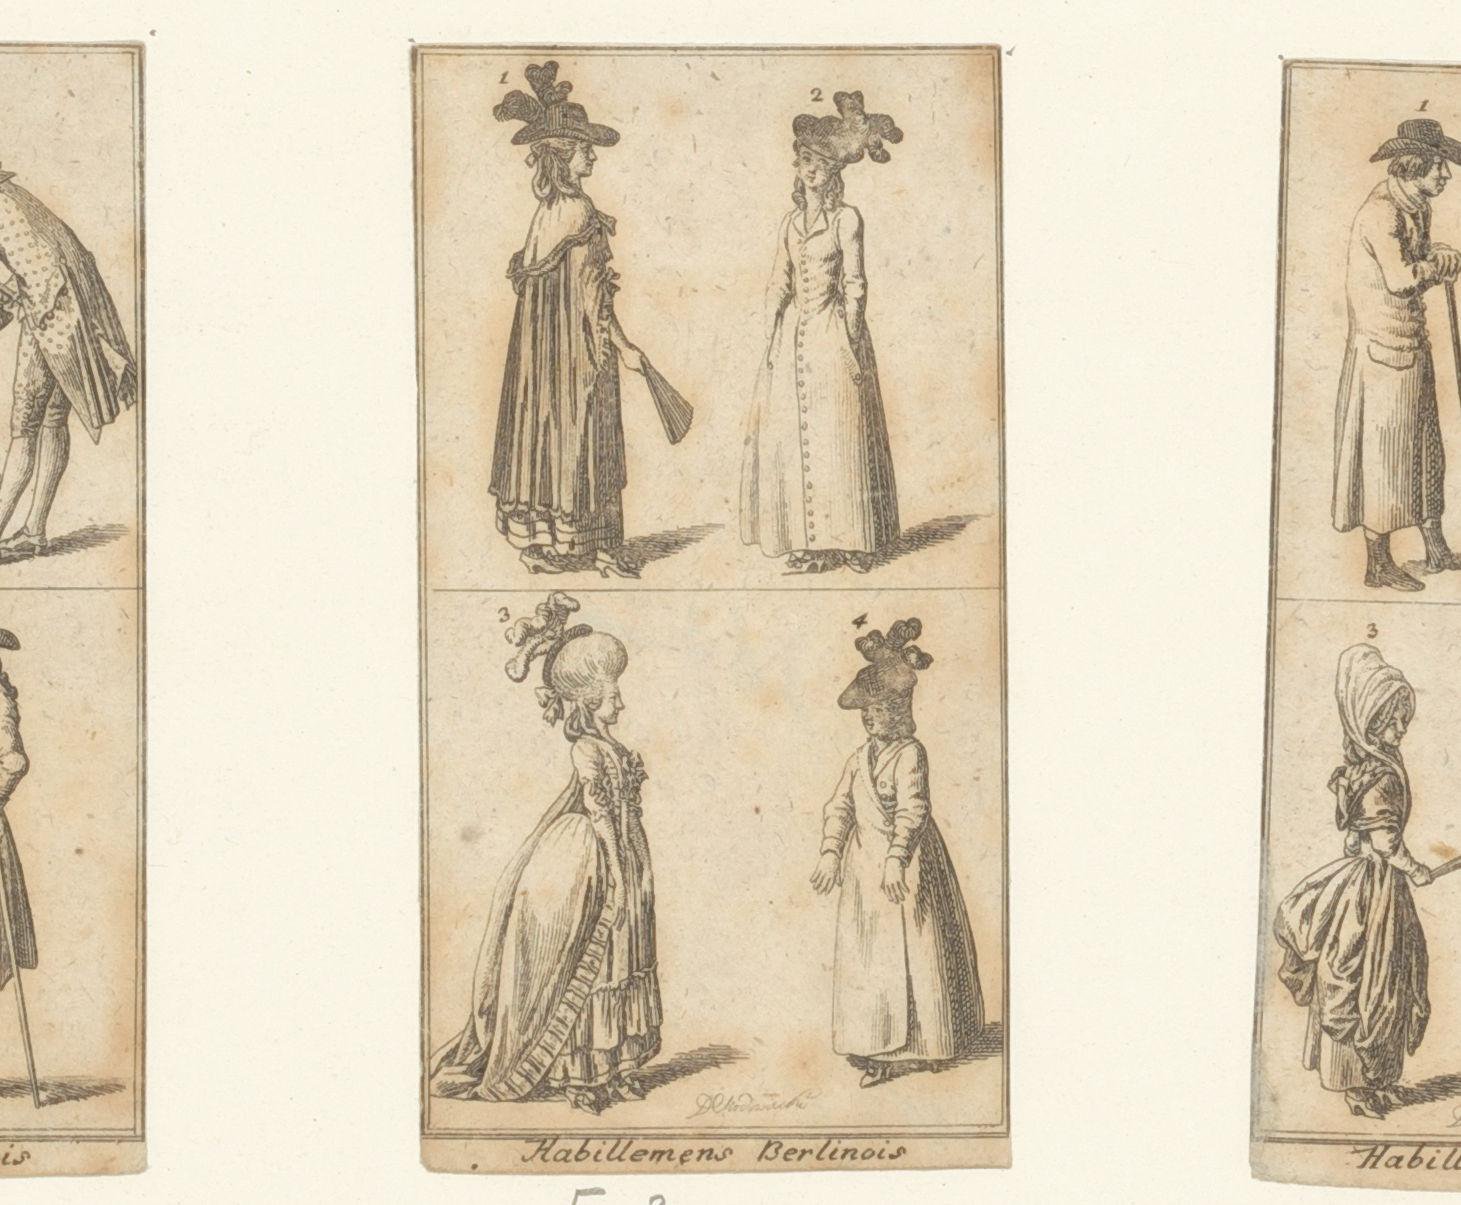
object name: print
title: Vier dames met verschillende gevederde hoeden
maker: daniel nikolaus chodowiecki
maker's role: draughtsman, print maker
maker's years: 1726-1801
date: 1778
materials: paper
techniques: etching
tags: styles of hairdress - aa - ~ women, dress, gown (+ women's clothes), historical costume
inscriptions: stamp, collector's mark: Lugt 1641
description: Afbeelding verdeelt in twee vakken. In ieder vak twee dames tegenover elkaar in Berlijnse mode. Onderwerpsrubrieken binnen de Atlas Zeden en Gewoonten: Zeden en Gewoonten in Engeren Zin, De Kleeding, Kleederdrachten (tijdvakken), De 18de eeuw (de pruikentijd). Mannen en vrouwen.